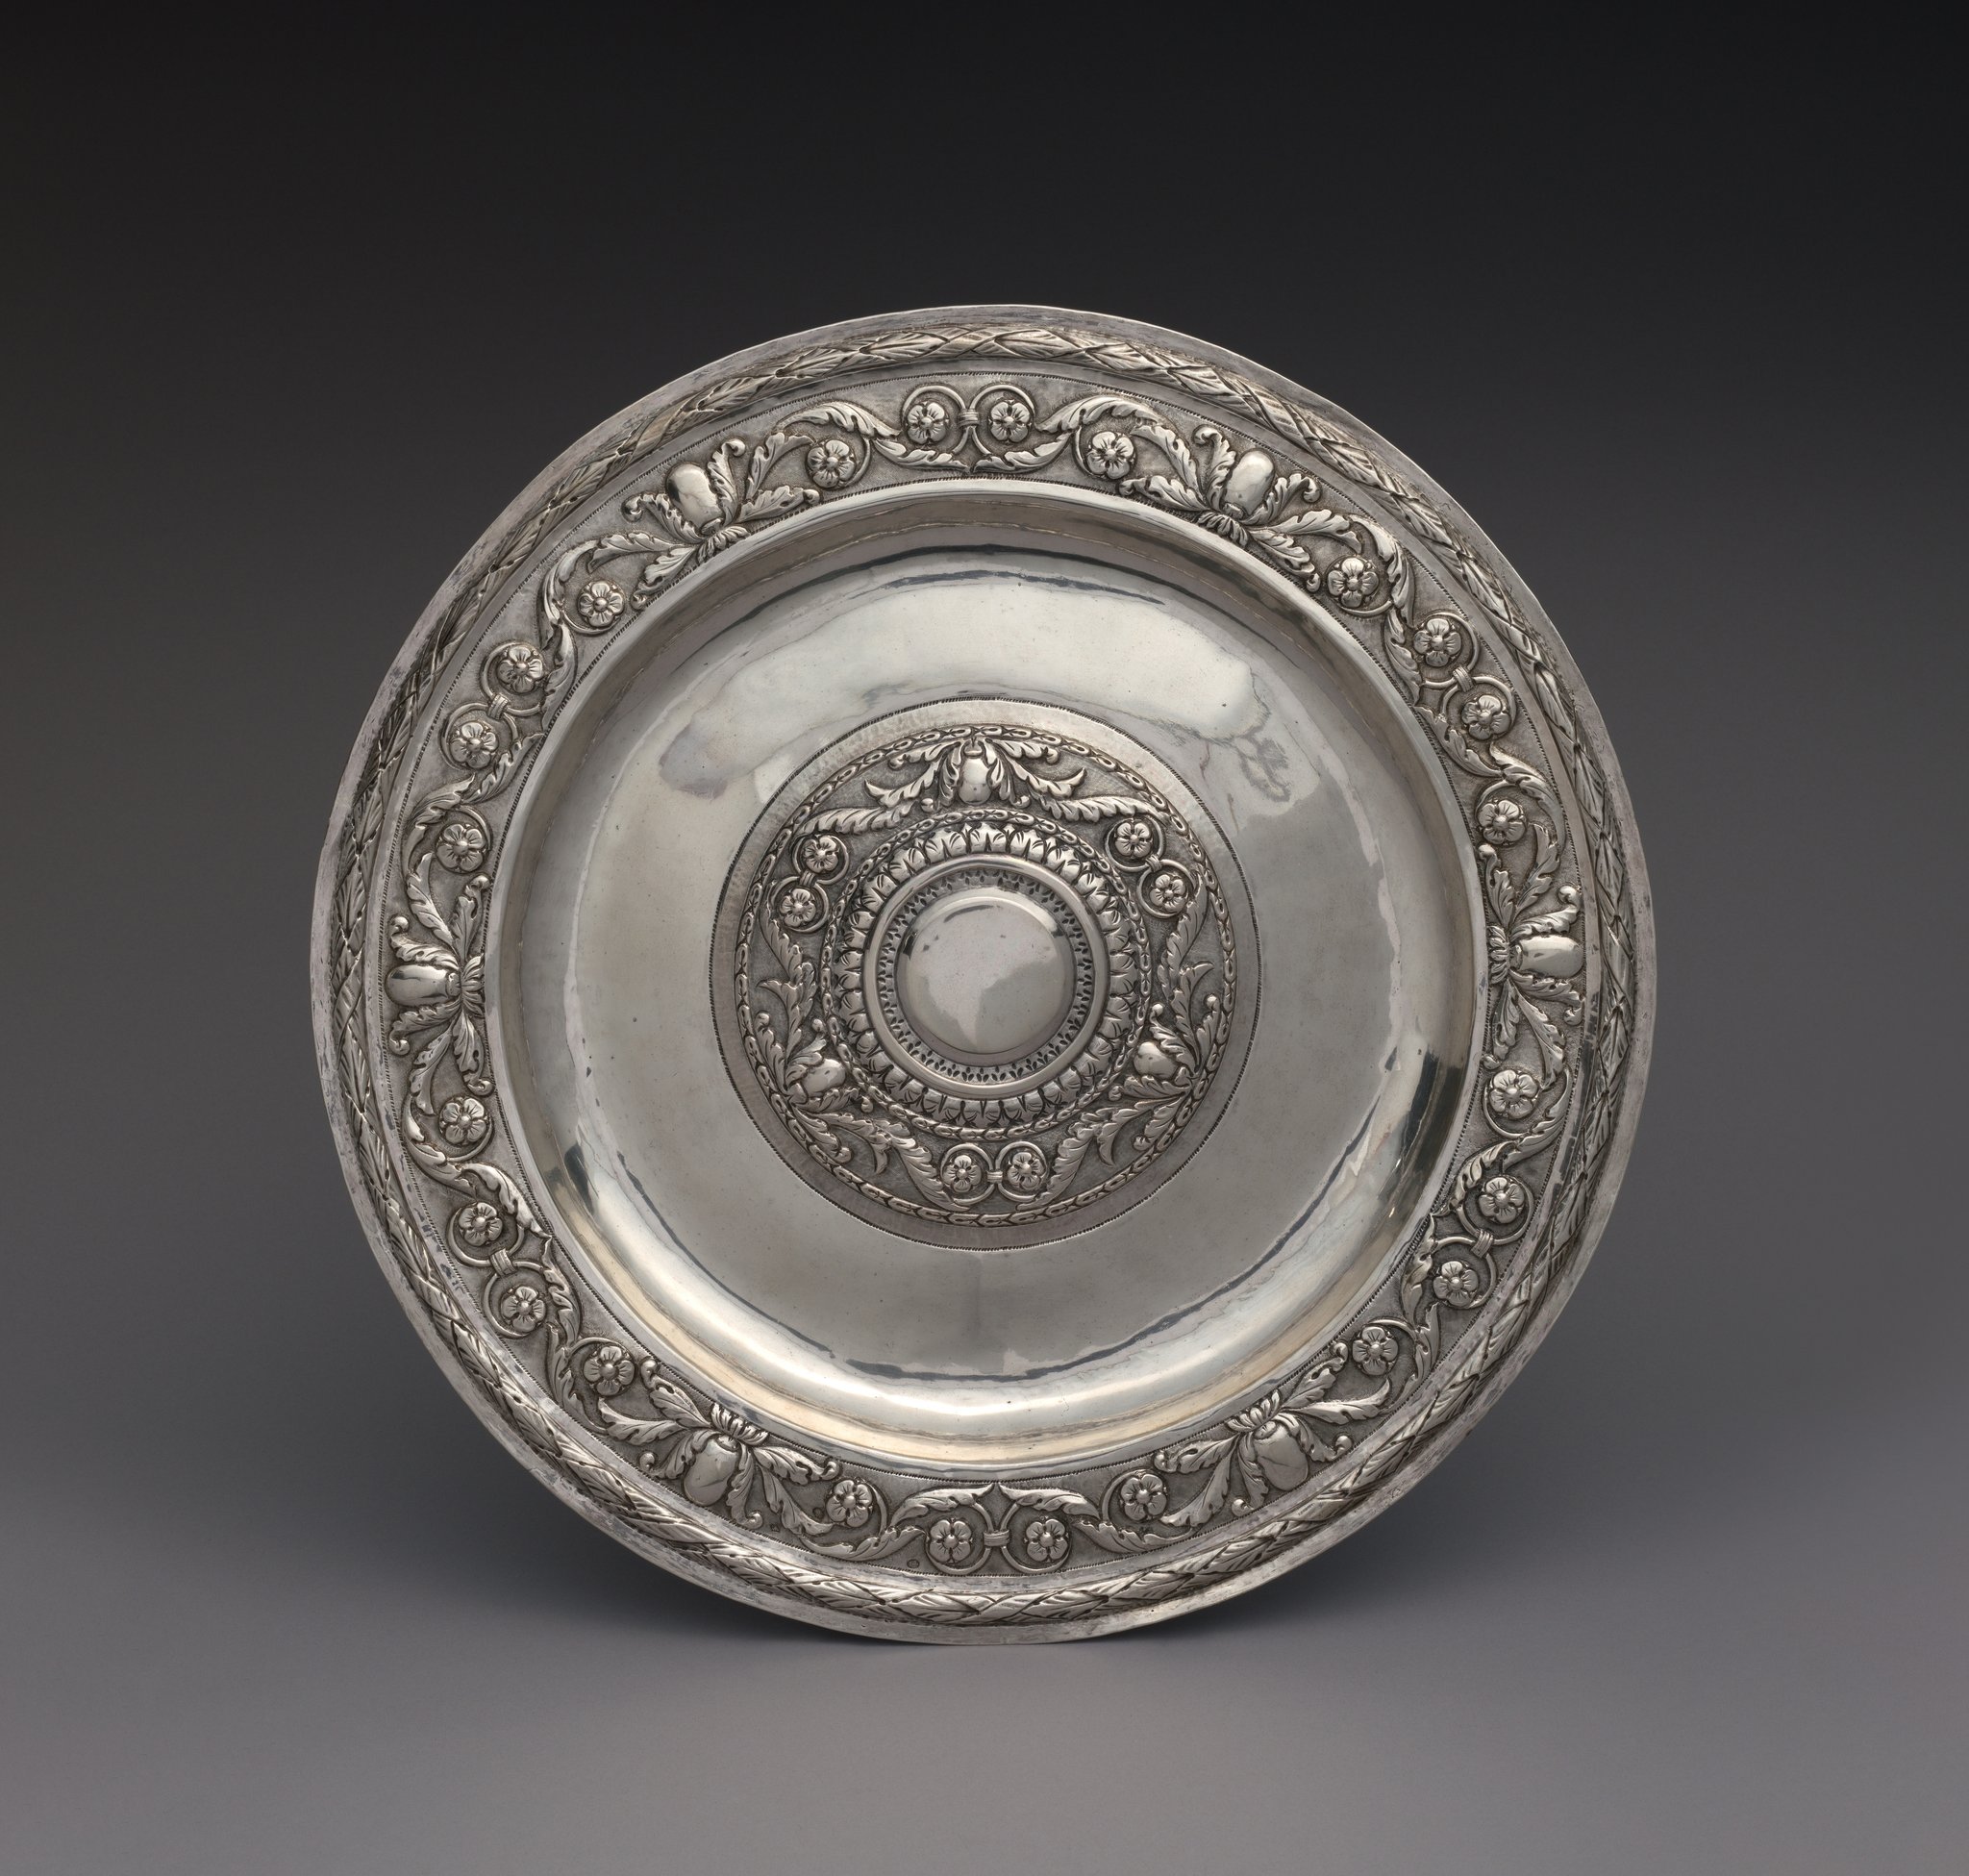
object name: seder plate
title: Passover seder plate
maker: israel lattes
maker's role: maker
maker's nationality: italian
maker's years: 1800-1899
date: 1824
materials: silver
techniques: embossing, engraving